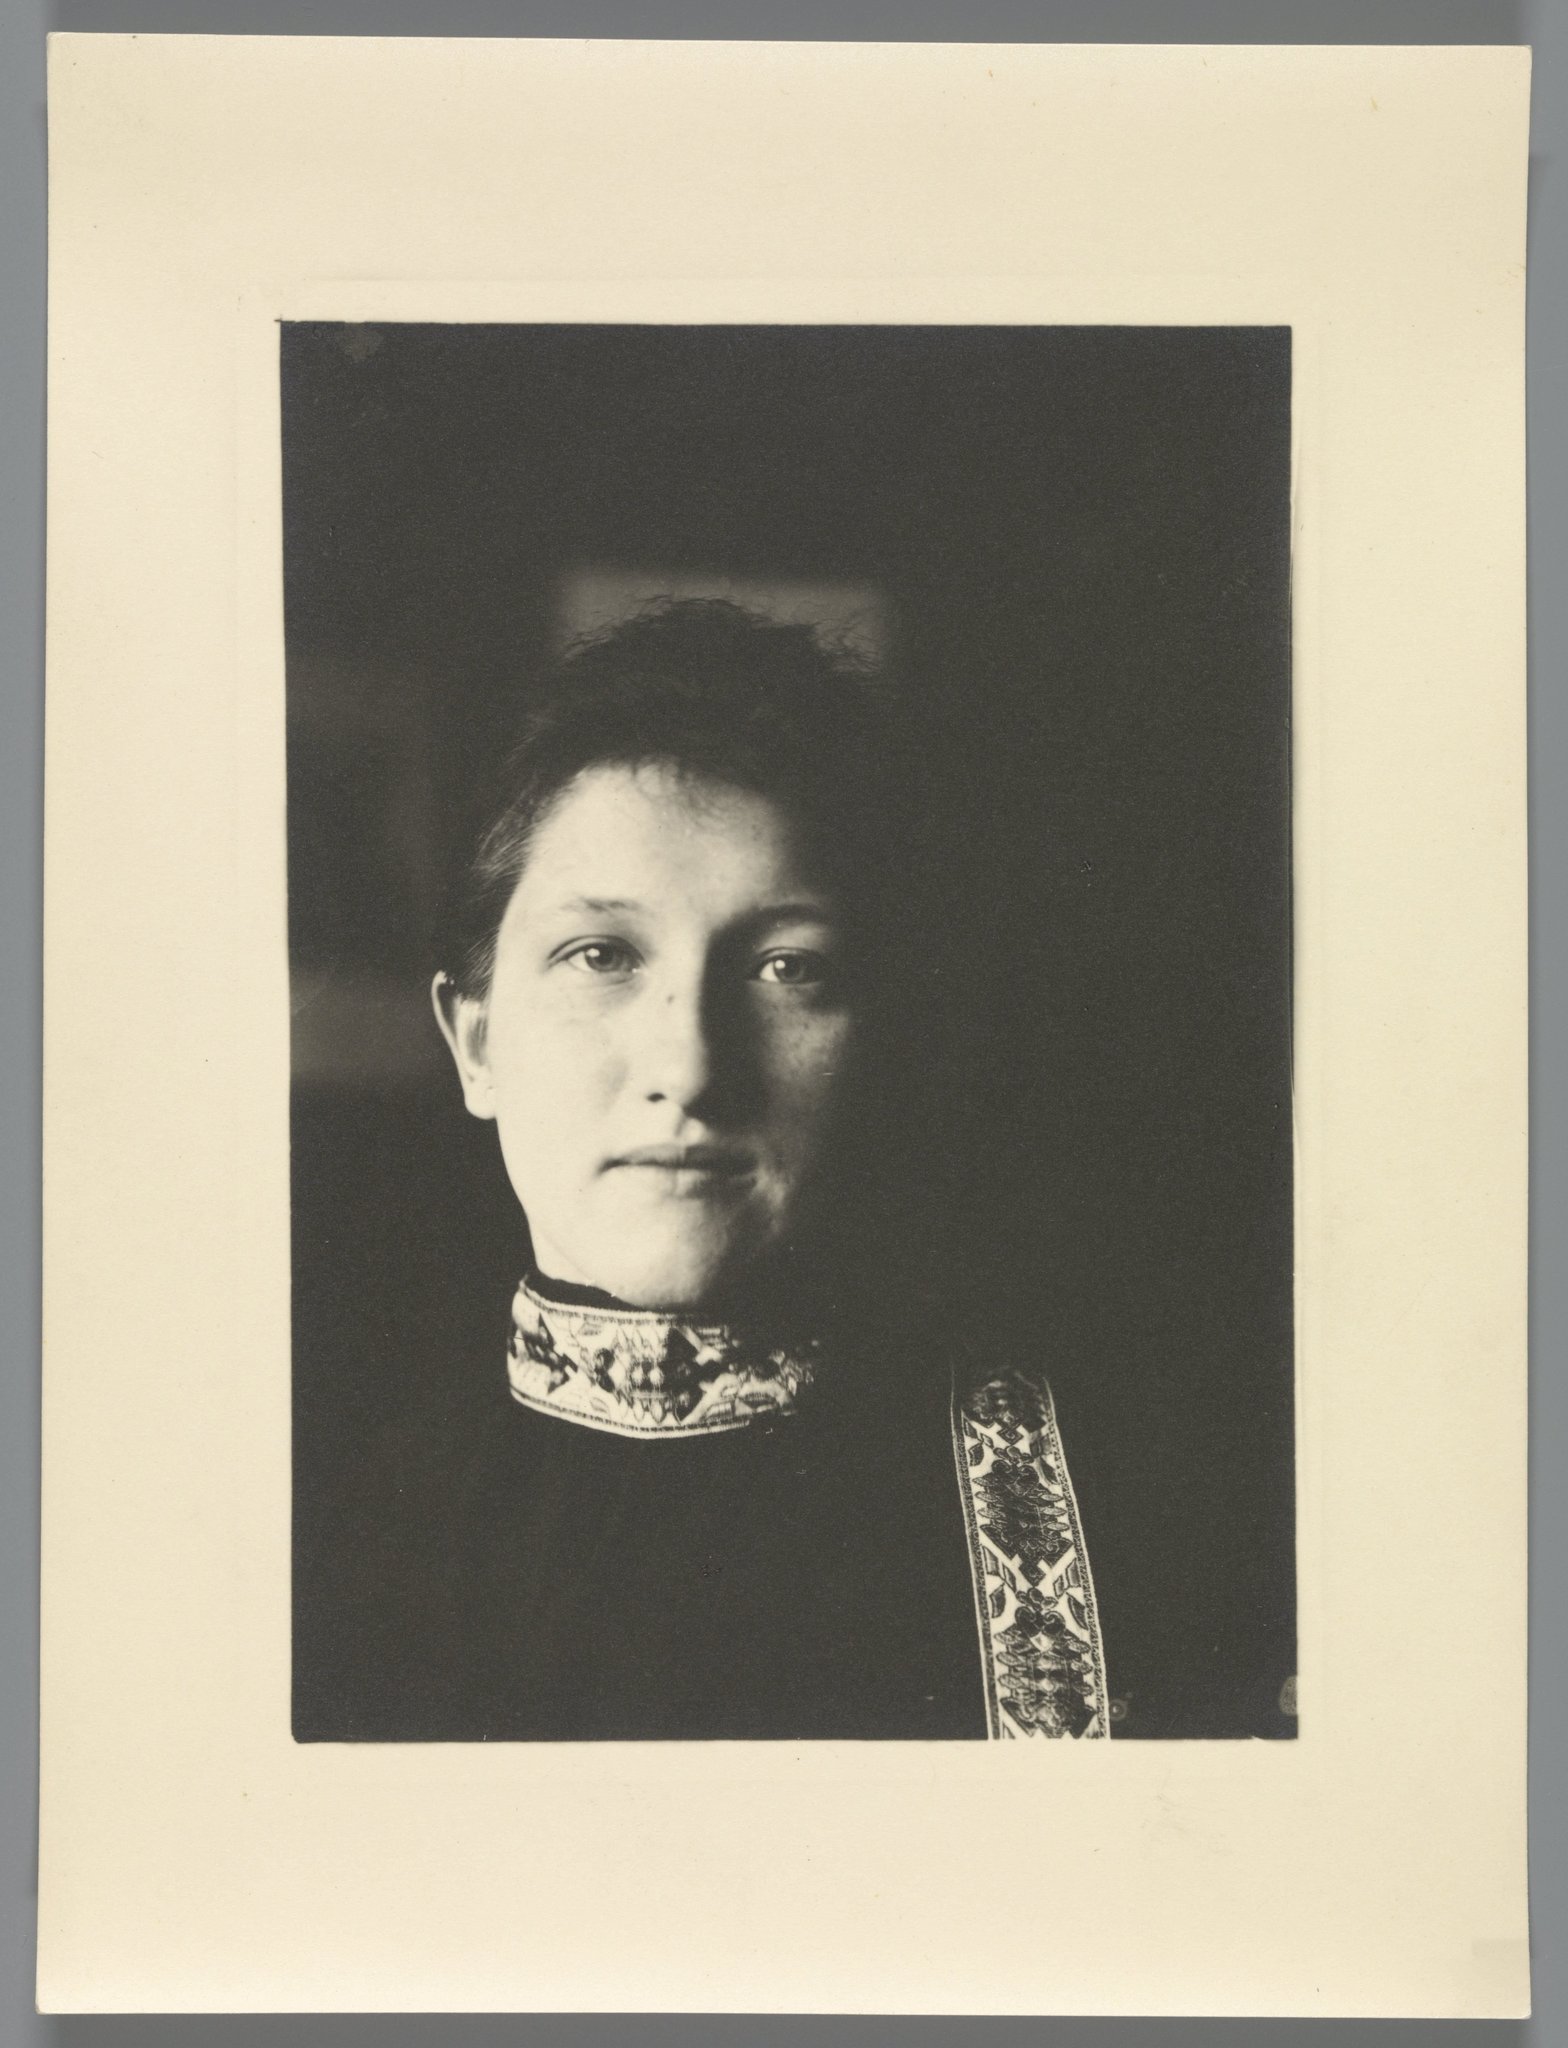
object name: photograph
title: Reproductie naar een fotoportret van Marie Koens, de latere echtgenote van Frank van der Goes door Willem Witsen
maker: Anonymous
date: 1860-1915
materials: paper, photographic support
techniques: gelatin silver print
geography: netherlands